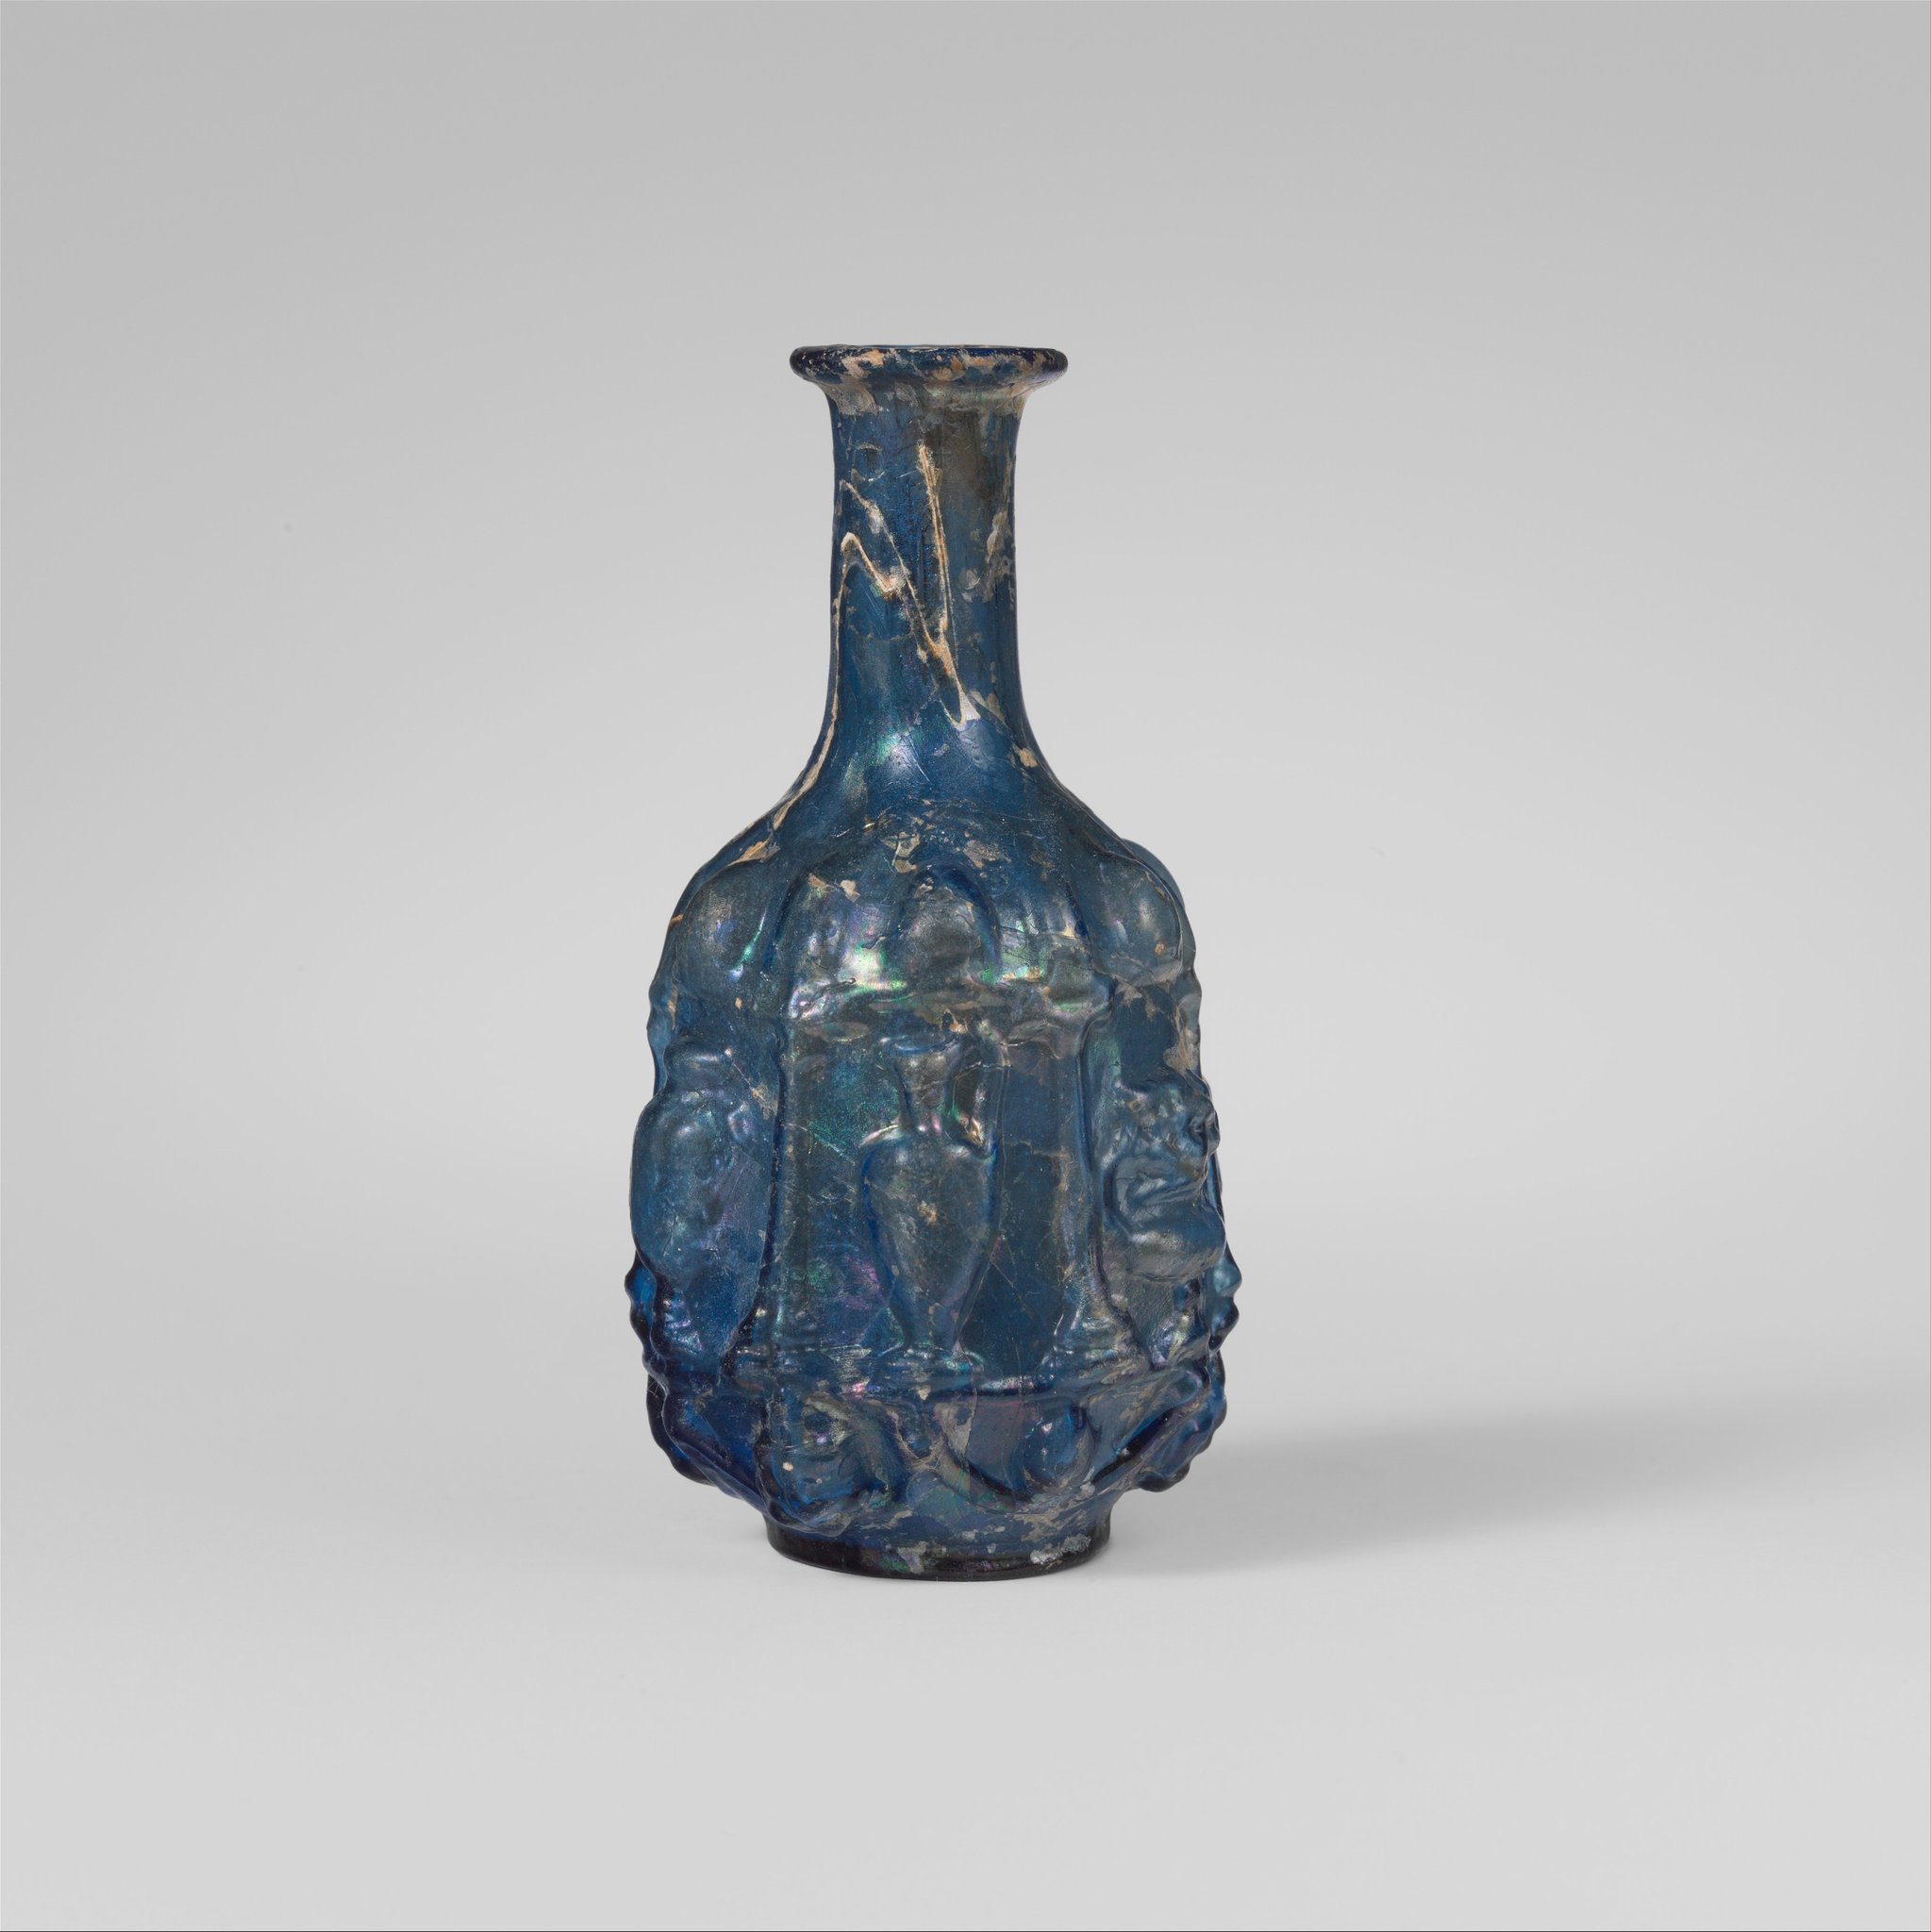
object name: bottle, hexagonal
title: Glass hexagonal bottle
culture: roman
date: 1-50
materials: glass